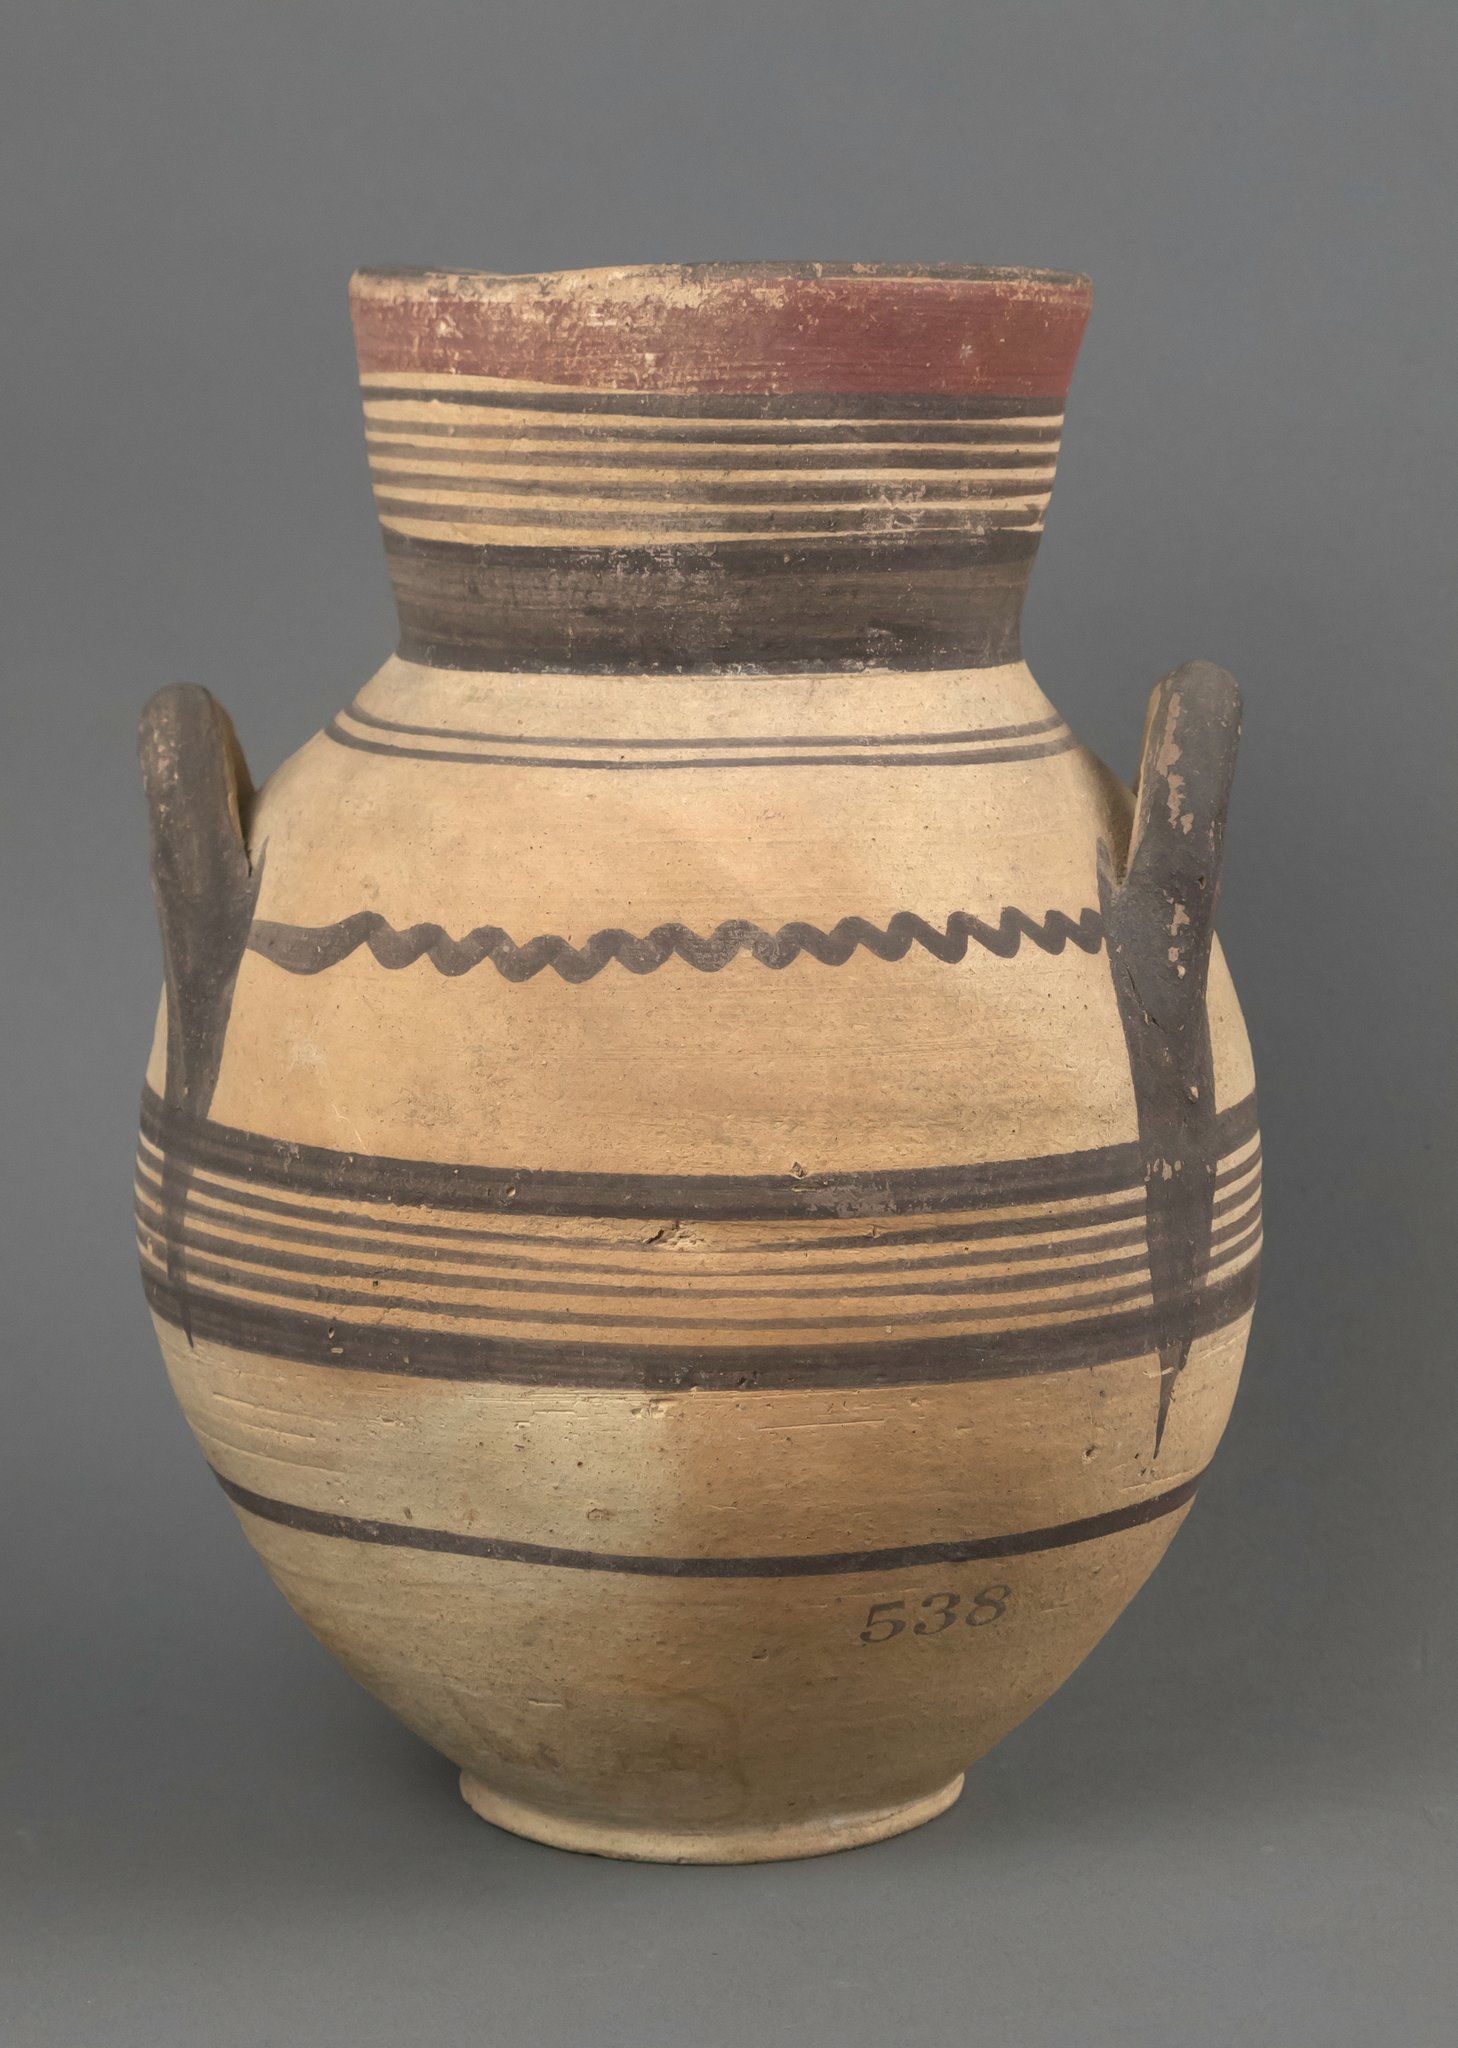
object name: amphora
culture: cypriot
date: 600-480 BCE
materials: terracotta